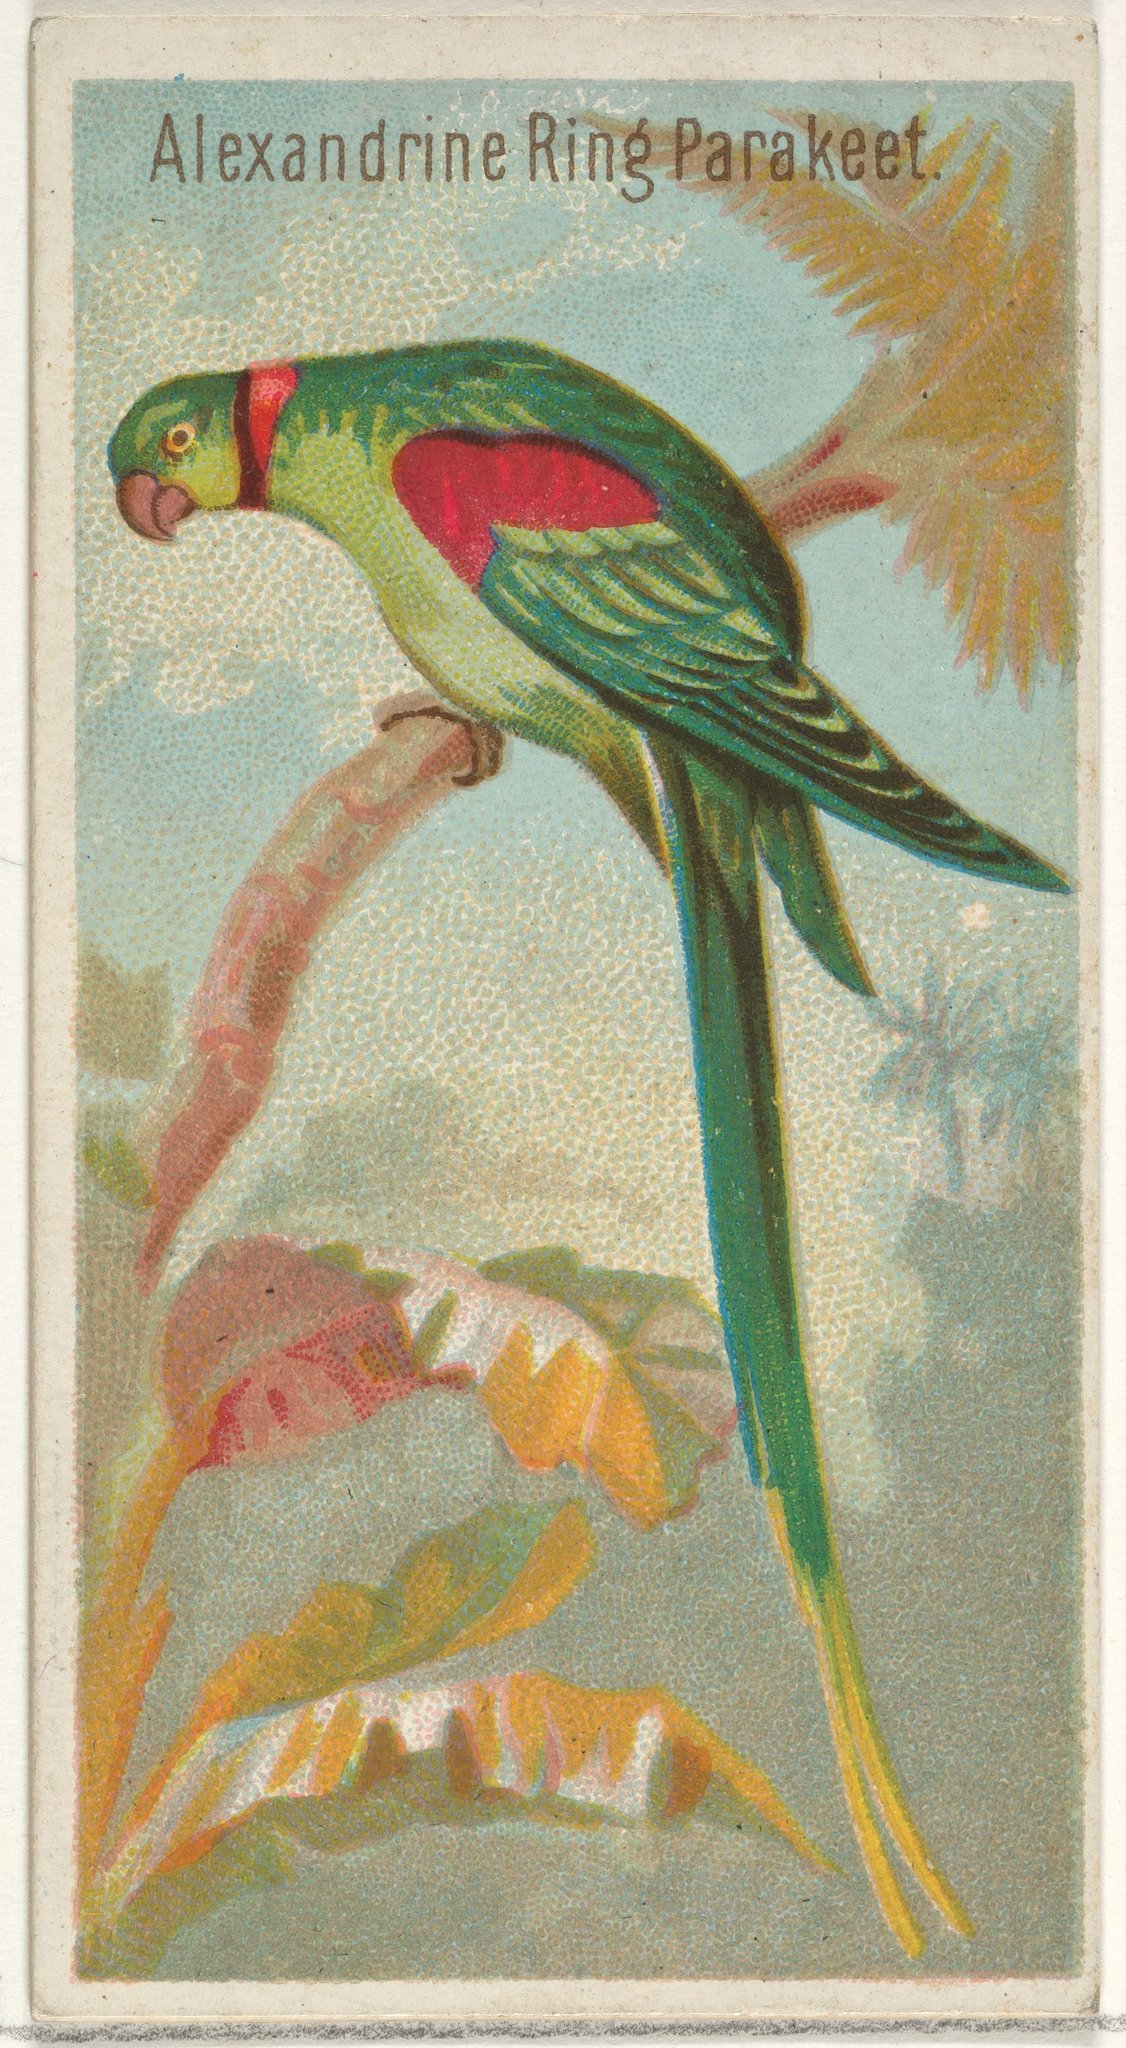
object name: print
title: Alexandrine Ring Parakeet, from the Birds of the Tropics series (N5) for Allen & Ginter Cigarettes Brands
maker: allen & ginter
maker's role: publisher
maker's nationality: american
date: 1889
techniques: color lithograph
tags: birds